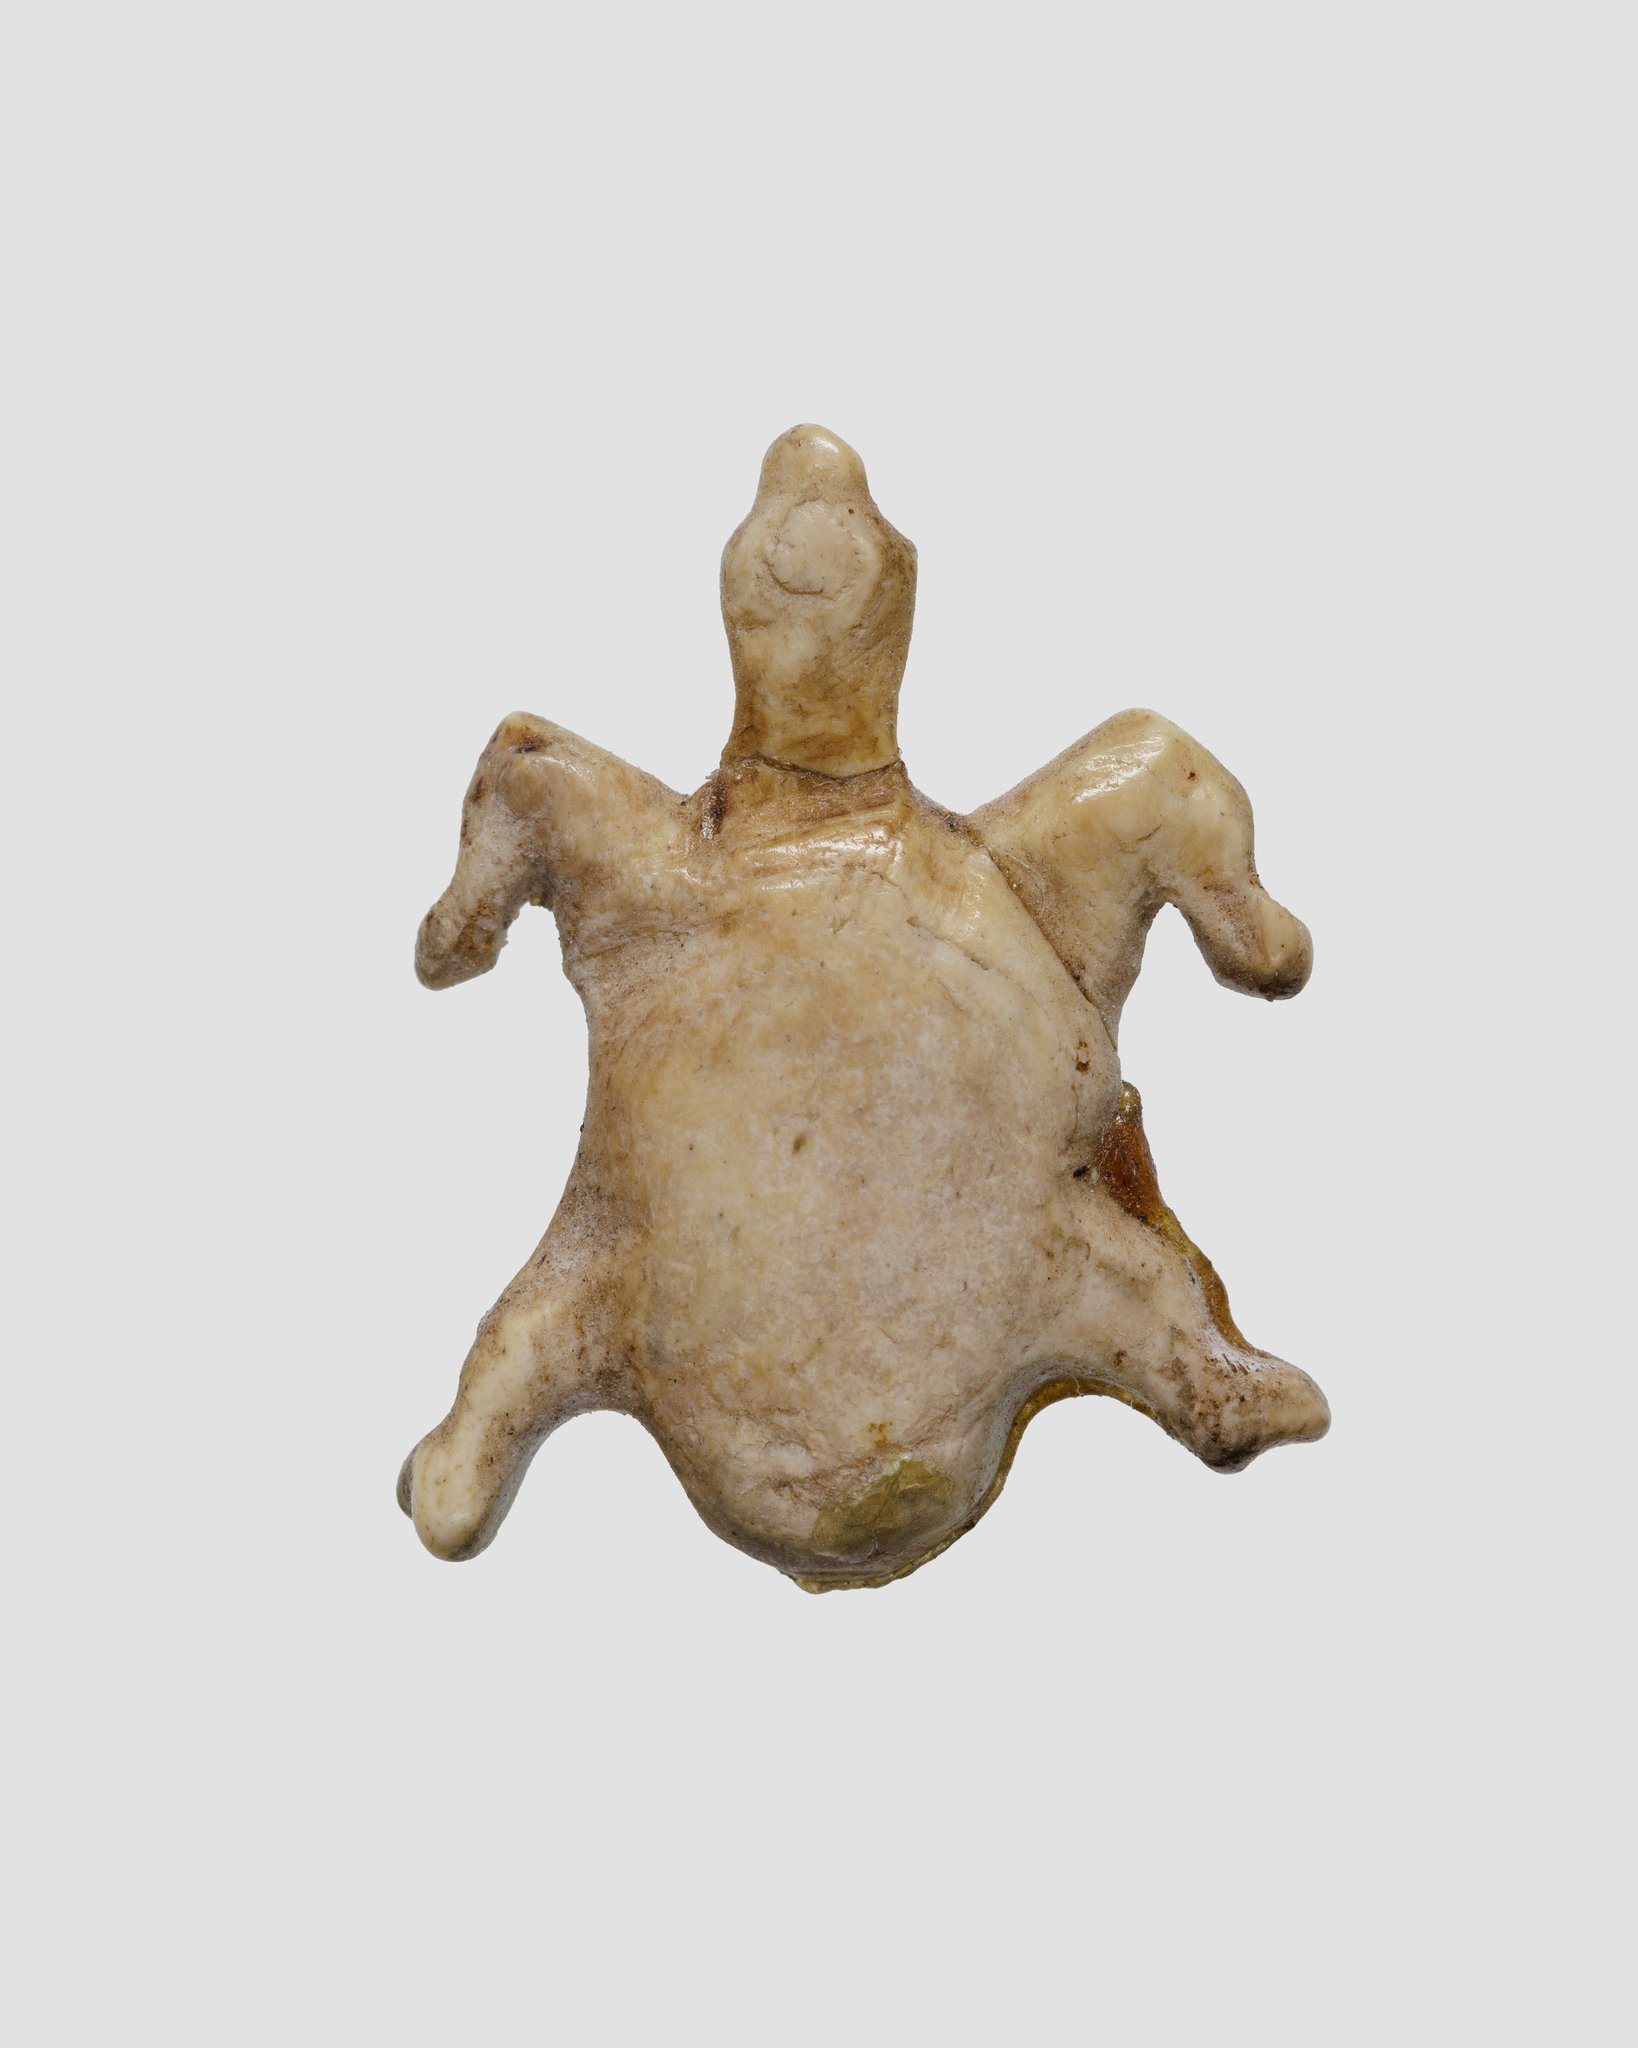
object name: amulet, turtle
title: Turtle amulet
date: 2150-1950 BCE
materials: bone, ivory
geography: egypt